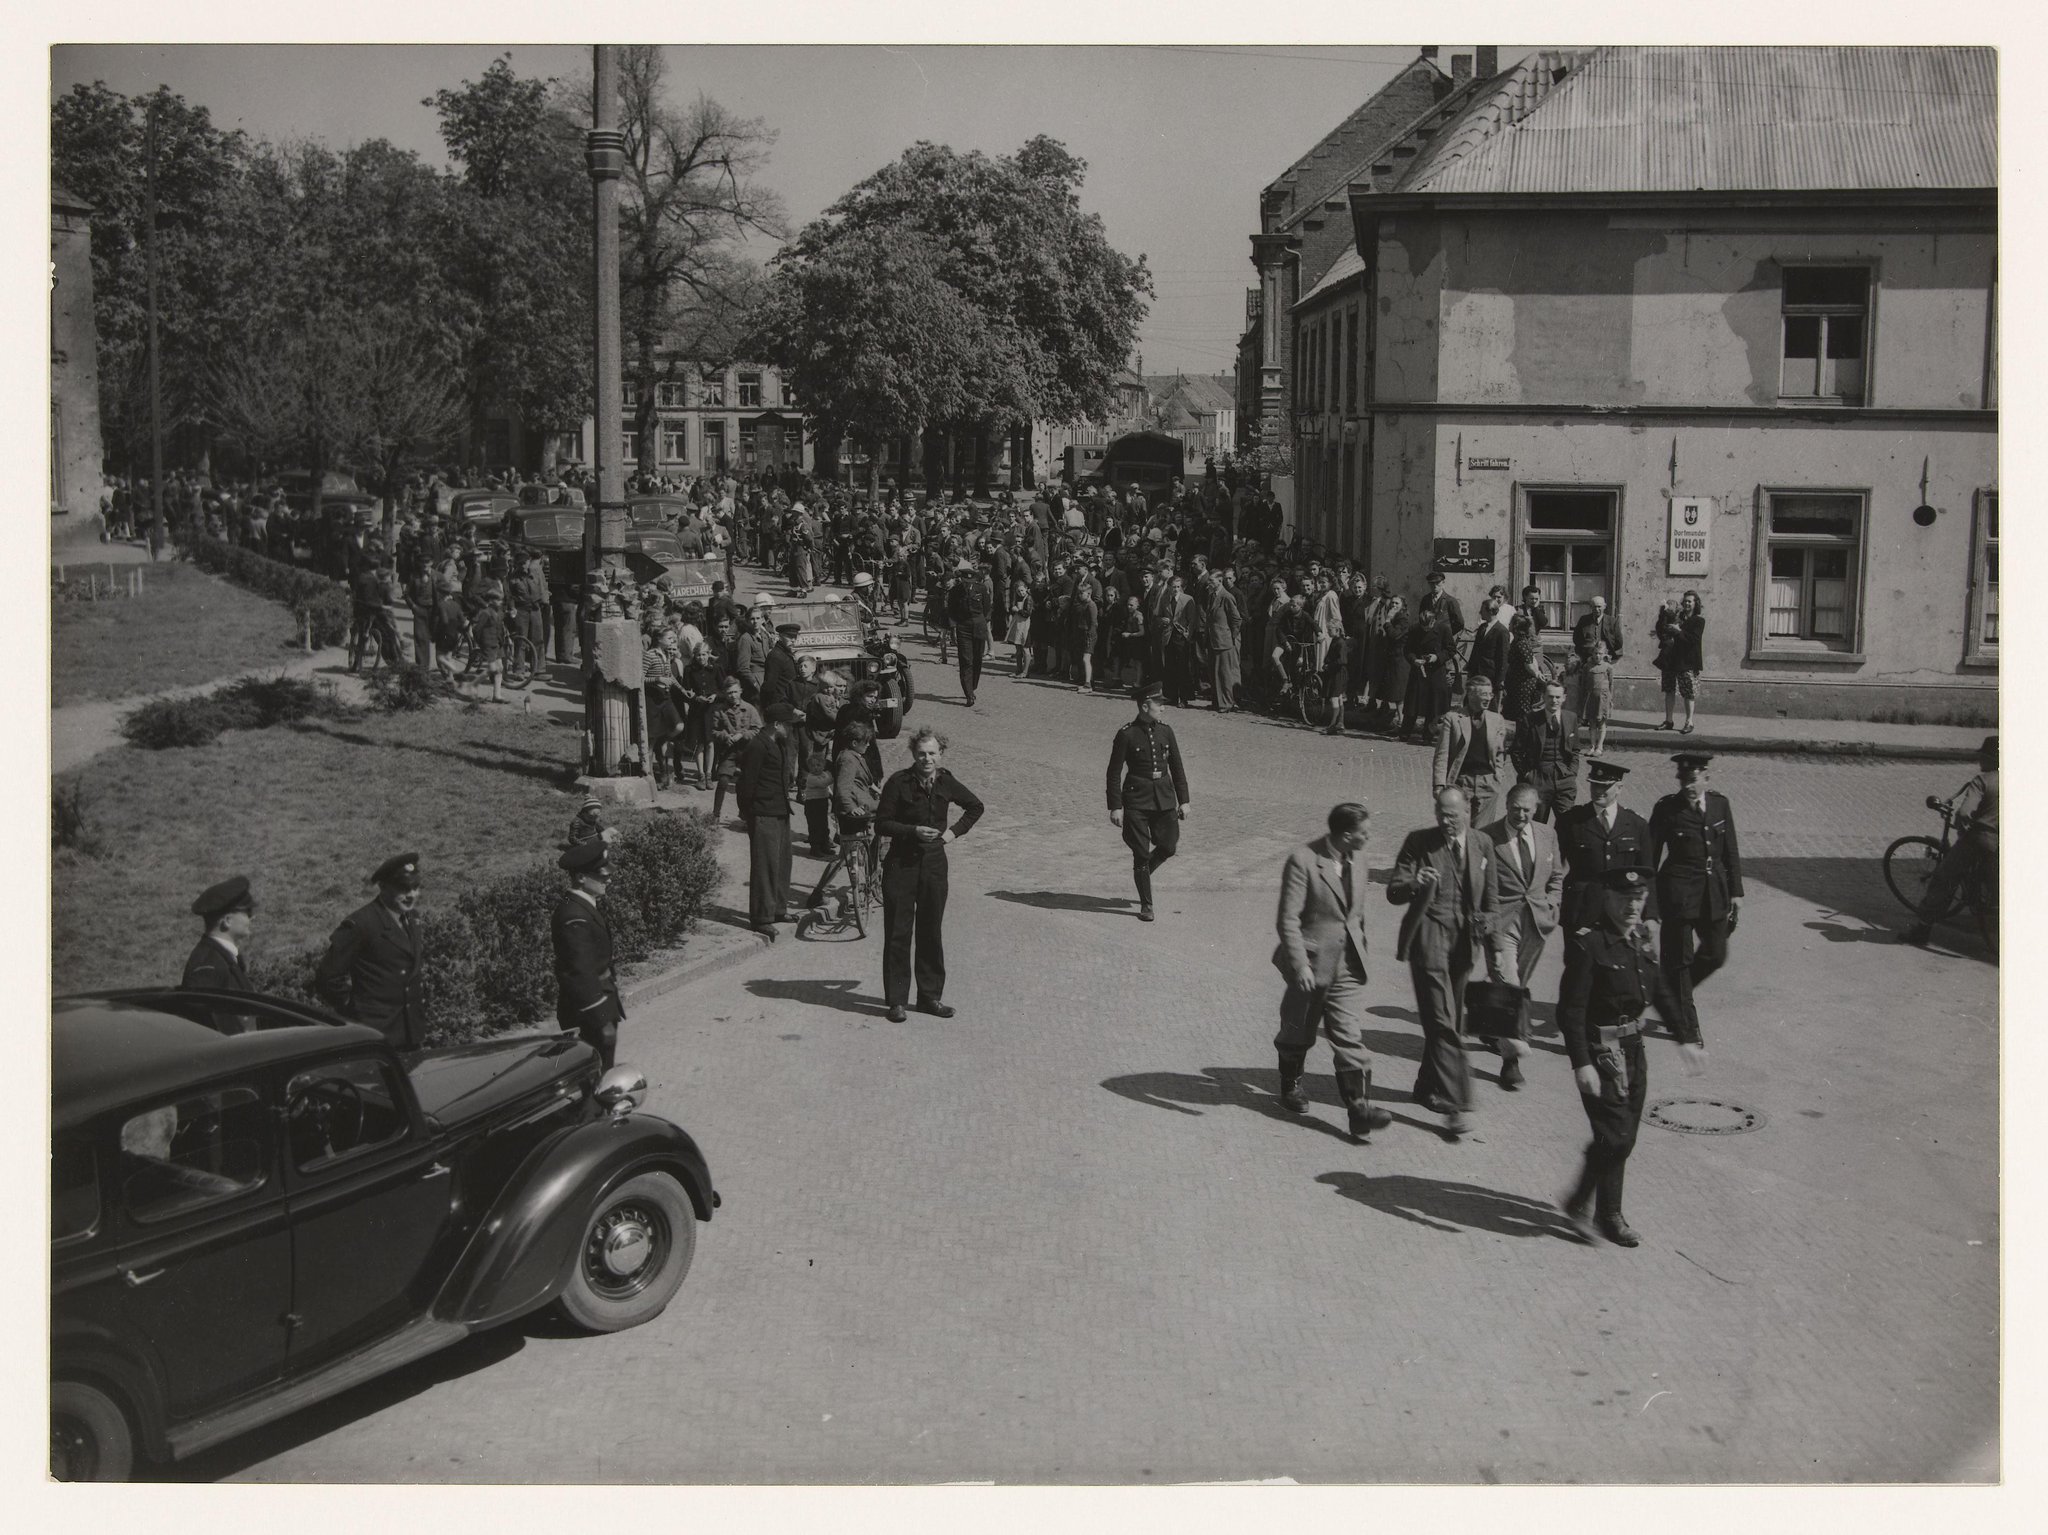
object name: documentary photograph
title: Nederlanders nemen de Duitse stad Elten over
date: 1949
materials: photographic support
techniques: photography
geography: elten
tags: elten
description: Nederlandse ambtenaren lopen over de marktplaats van Elten op weg naar het stadhuis waar de bestuursoverdacht van het gebied zal plaatsvinden. Op de marktplaats staan een luxe auto's gereed met chauffeur. De plaatselijke bevolking is uitgelopen om de ceremonie gade te slaan.